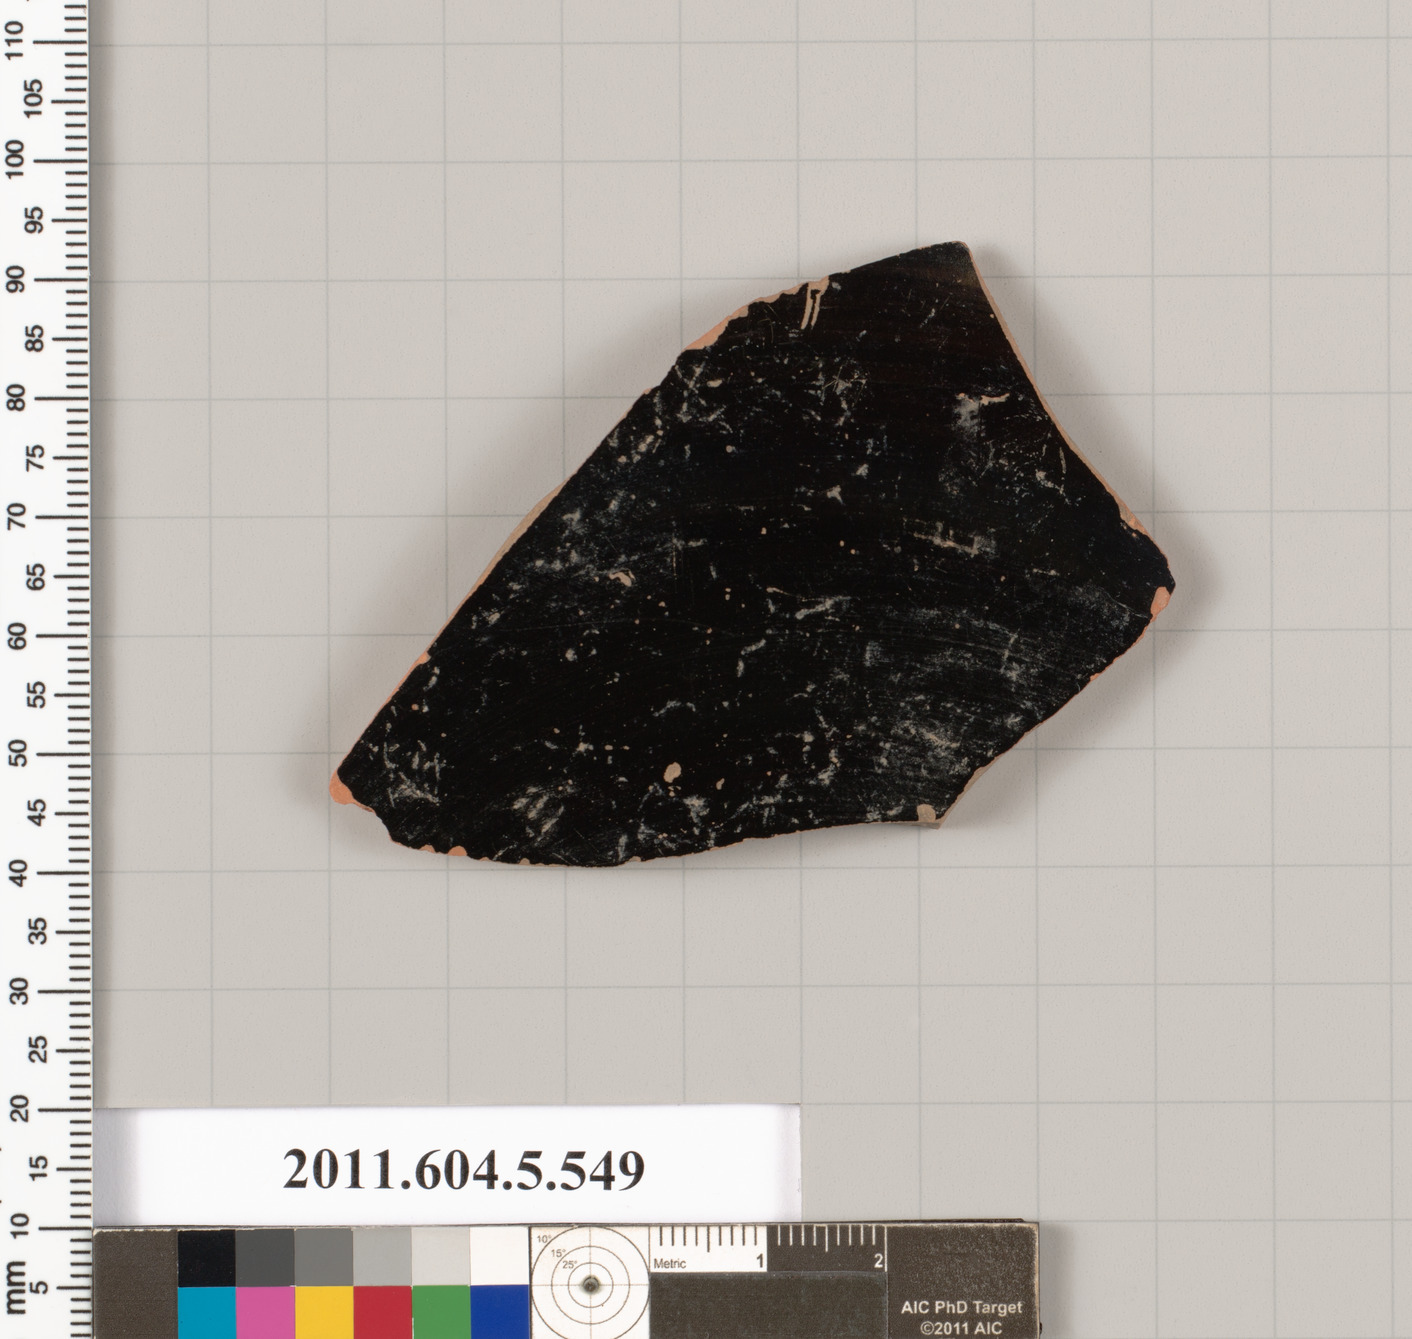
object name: kylix fragment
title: Terracotta fragment of a kylix (drinking cup)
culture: greek, attic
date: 600-401 BCE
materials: terracotta